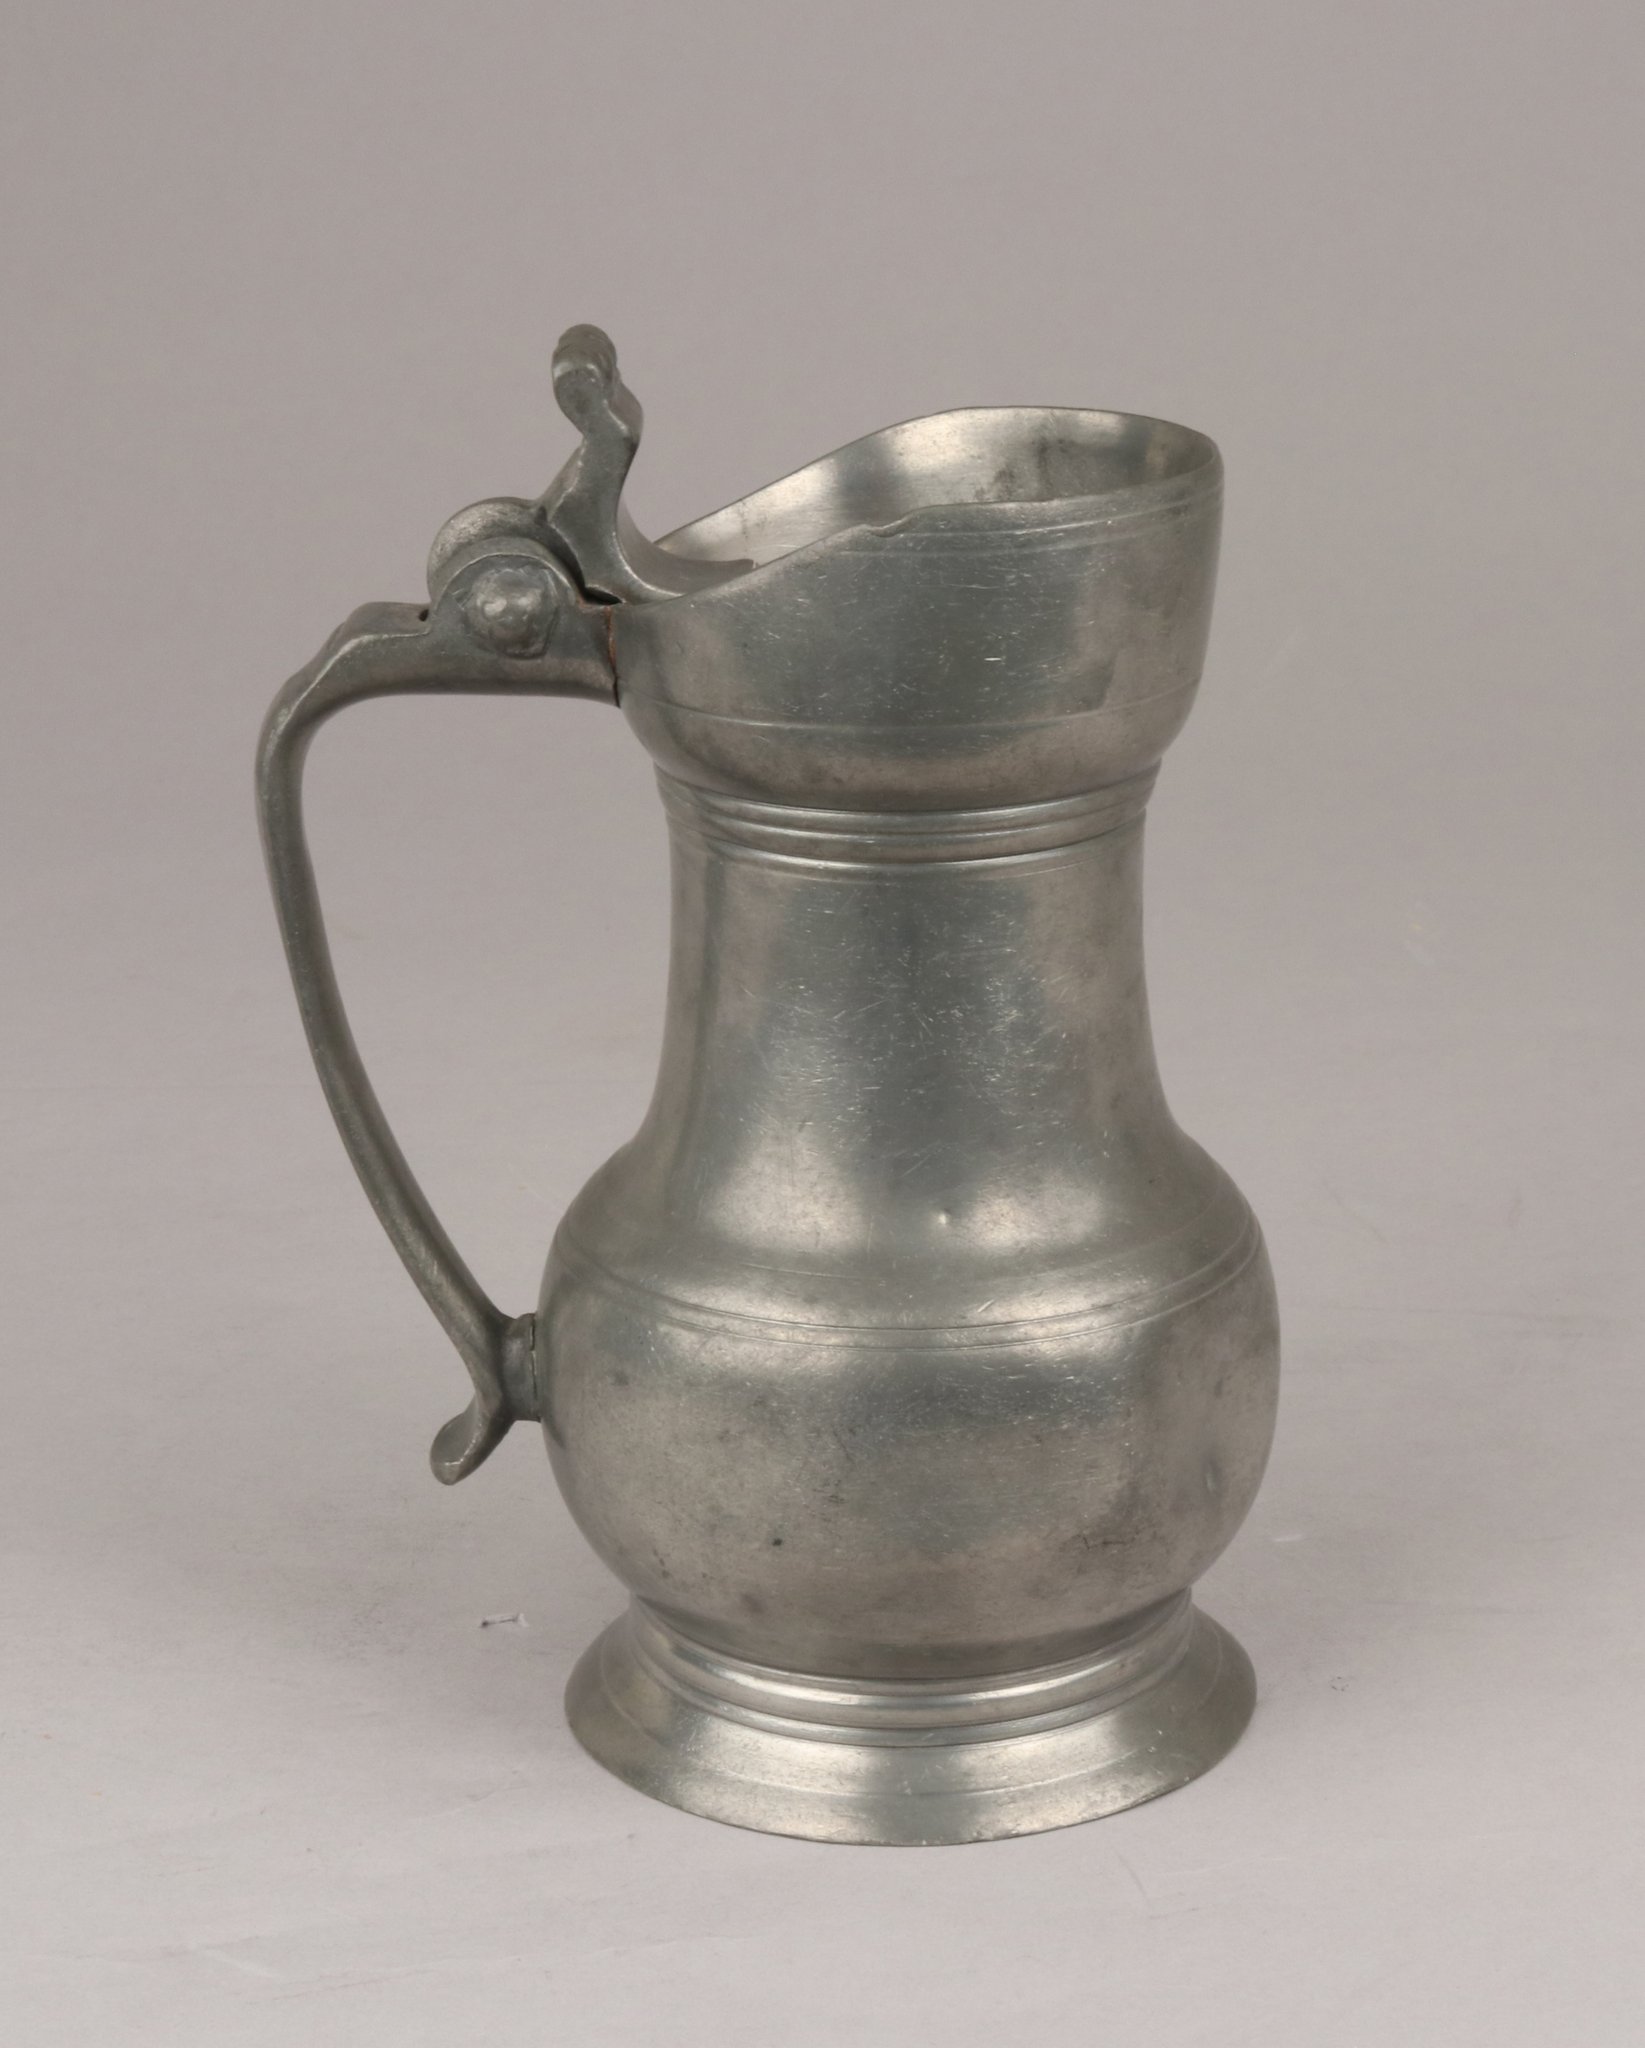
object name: pitcher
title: Pitcher (Pichet balustre avec gobelet en botte)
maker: charles vovelle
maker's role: maker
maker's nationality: french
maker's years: 1850-1921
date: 1867-1900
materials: pewter